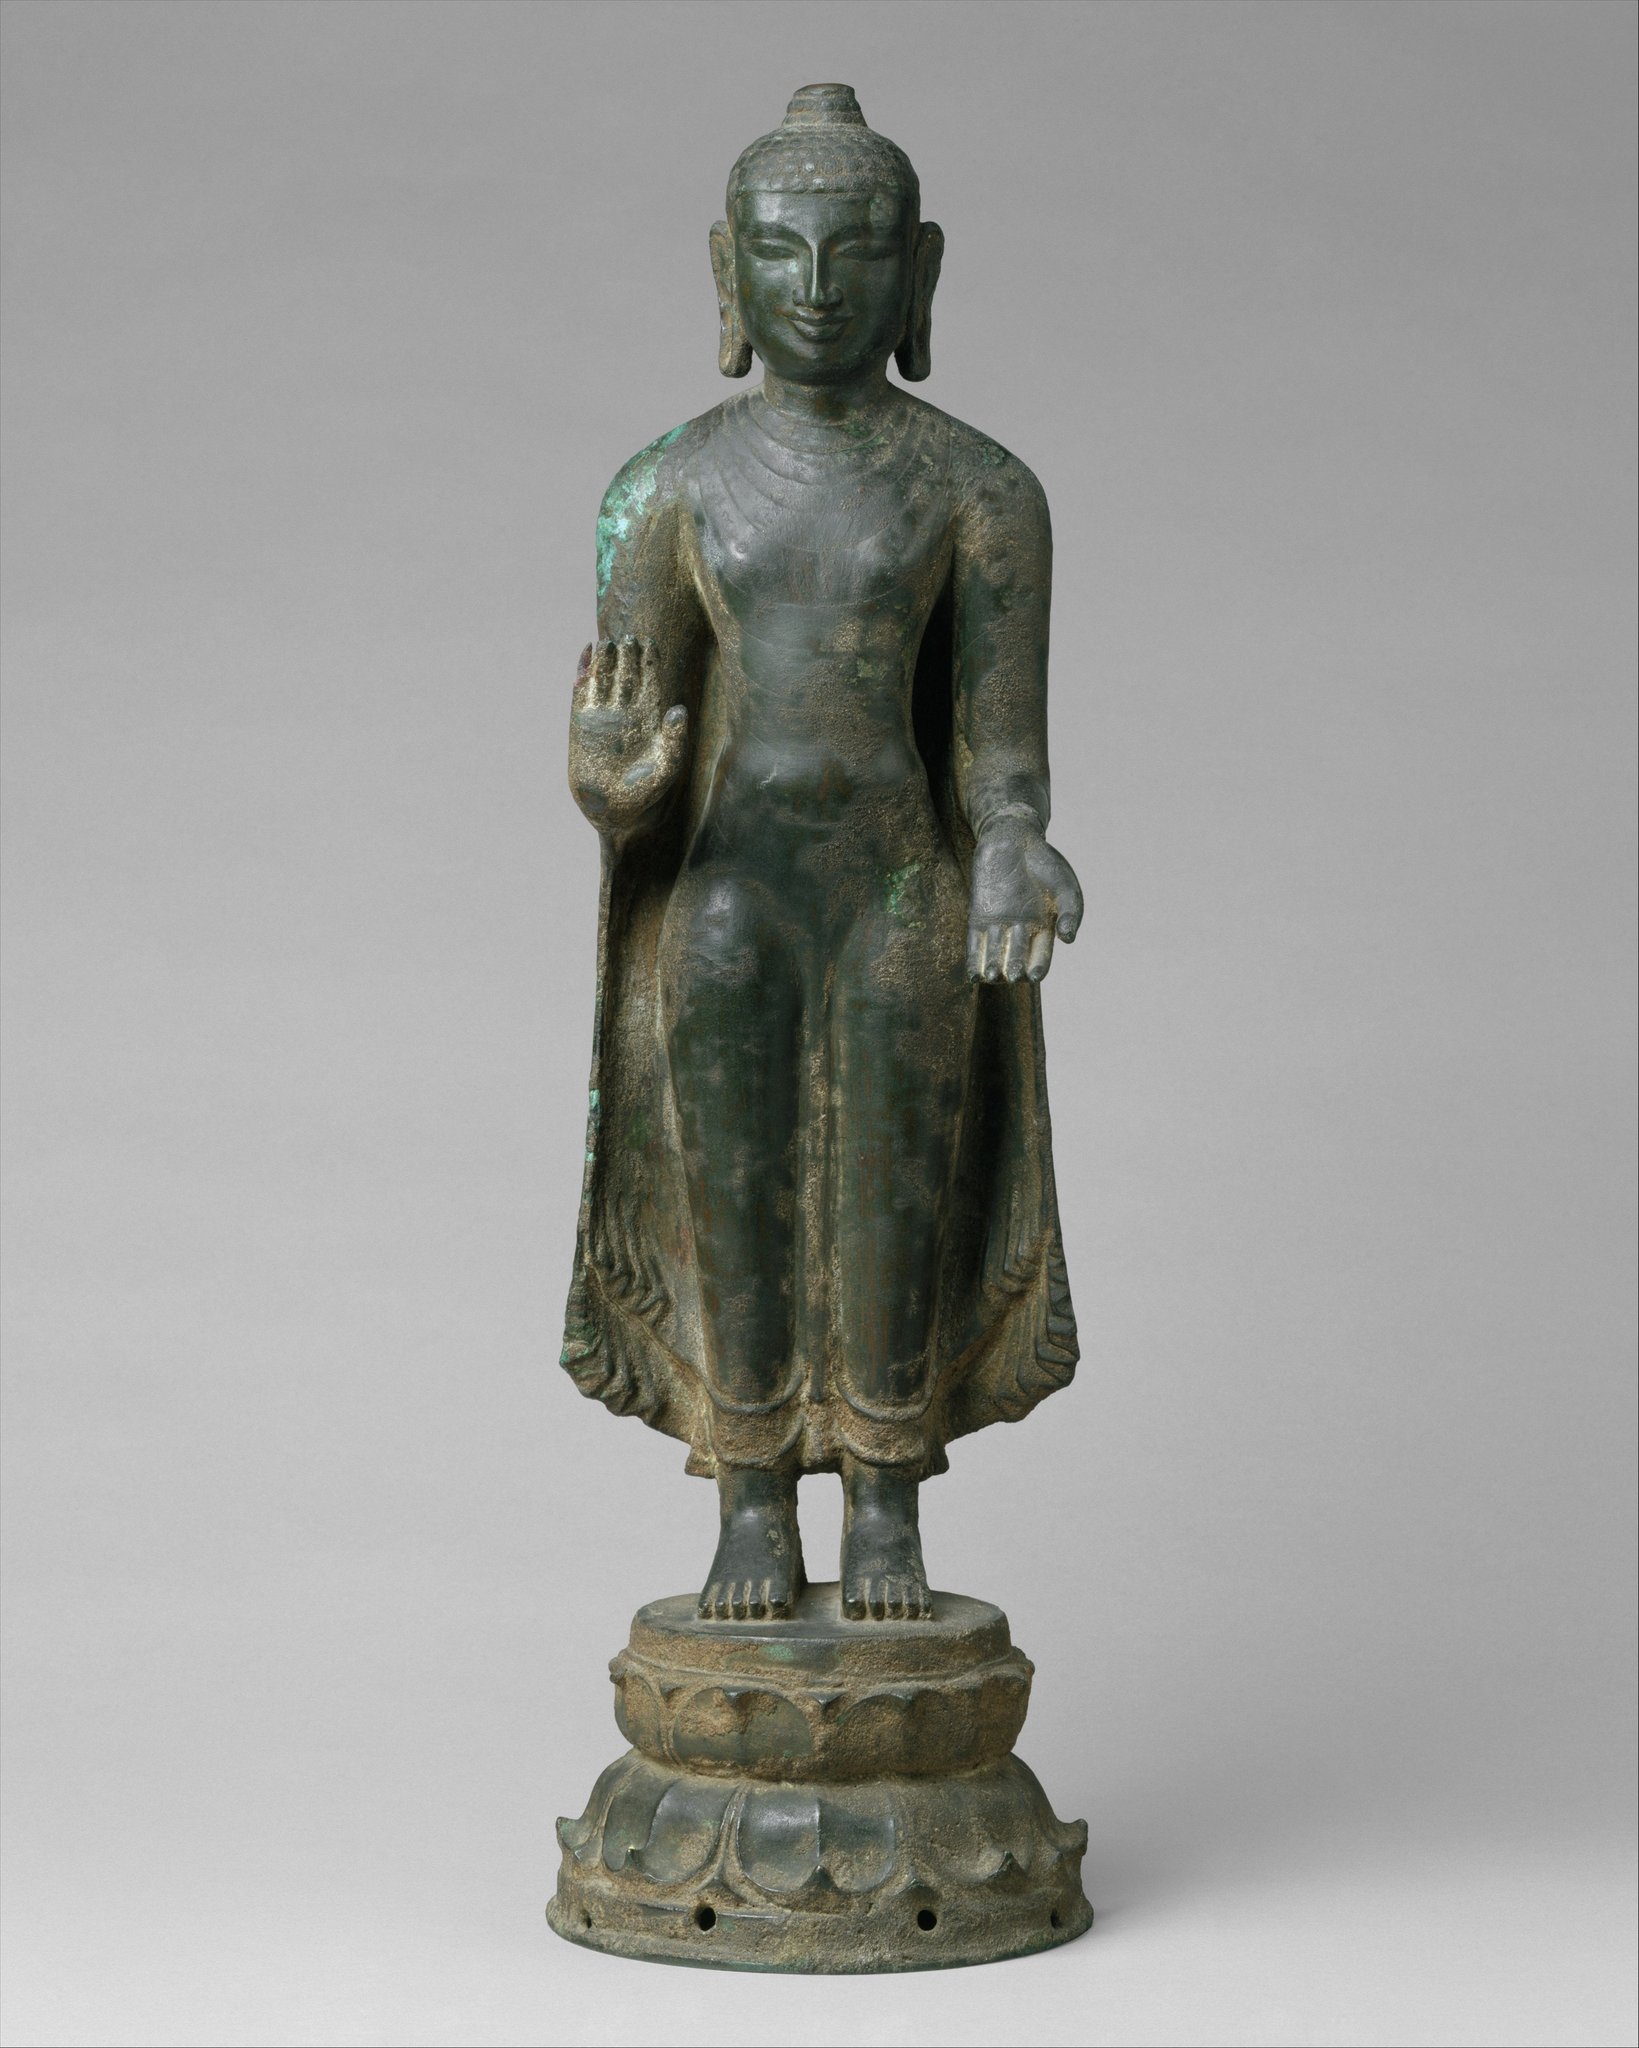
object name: figure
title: Buddha Offering Protection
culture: indian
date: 1001-1200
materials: copper alloy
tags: later andhra,buddhism,buddha